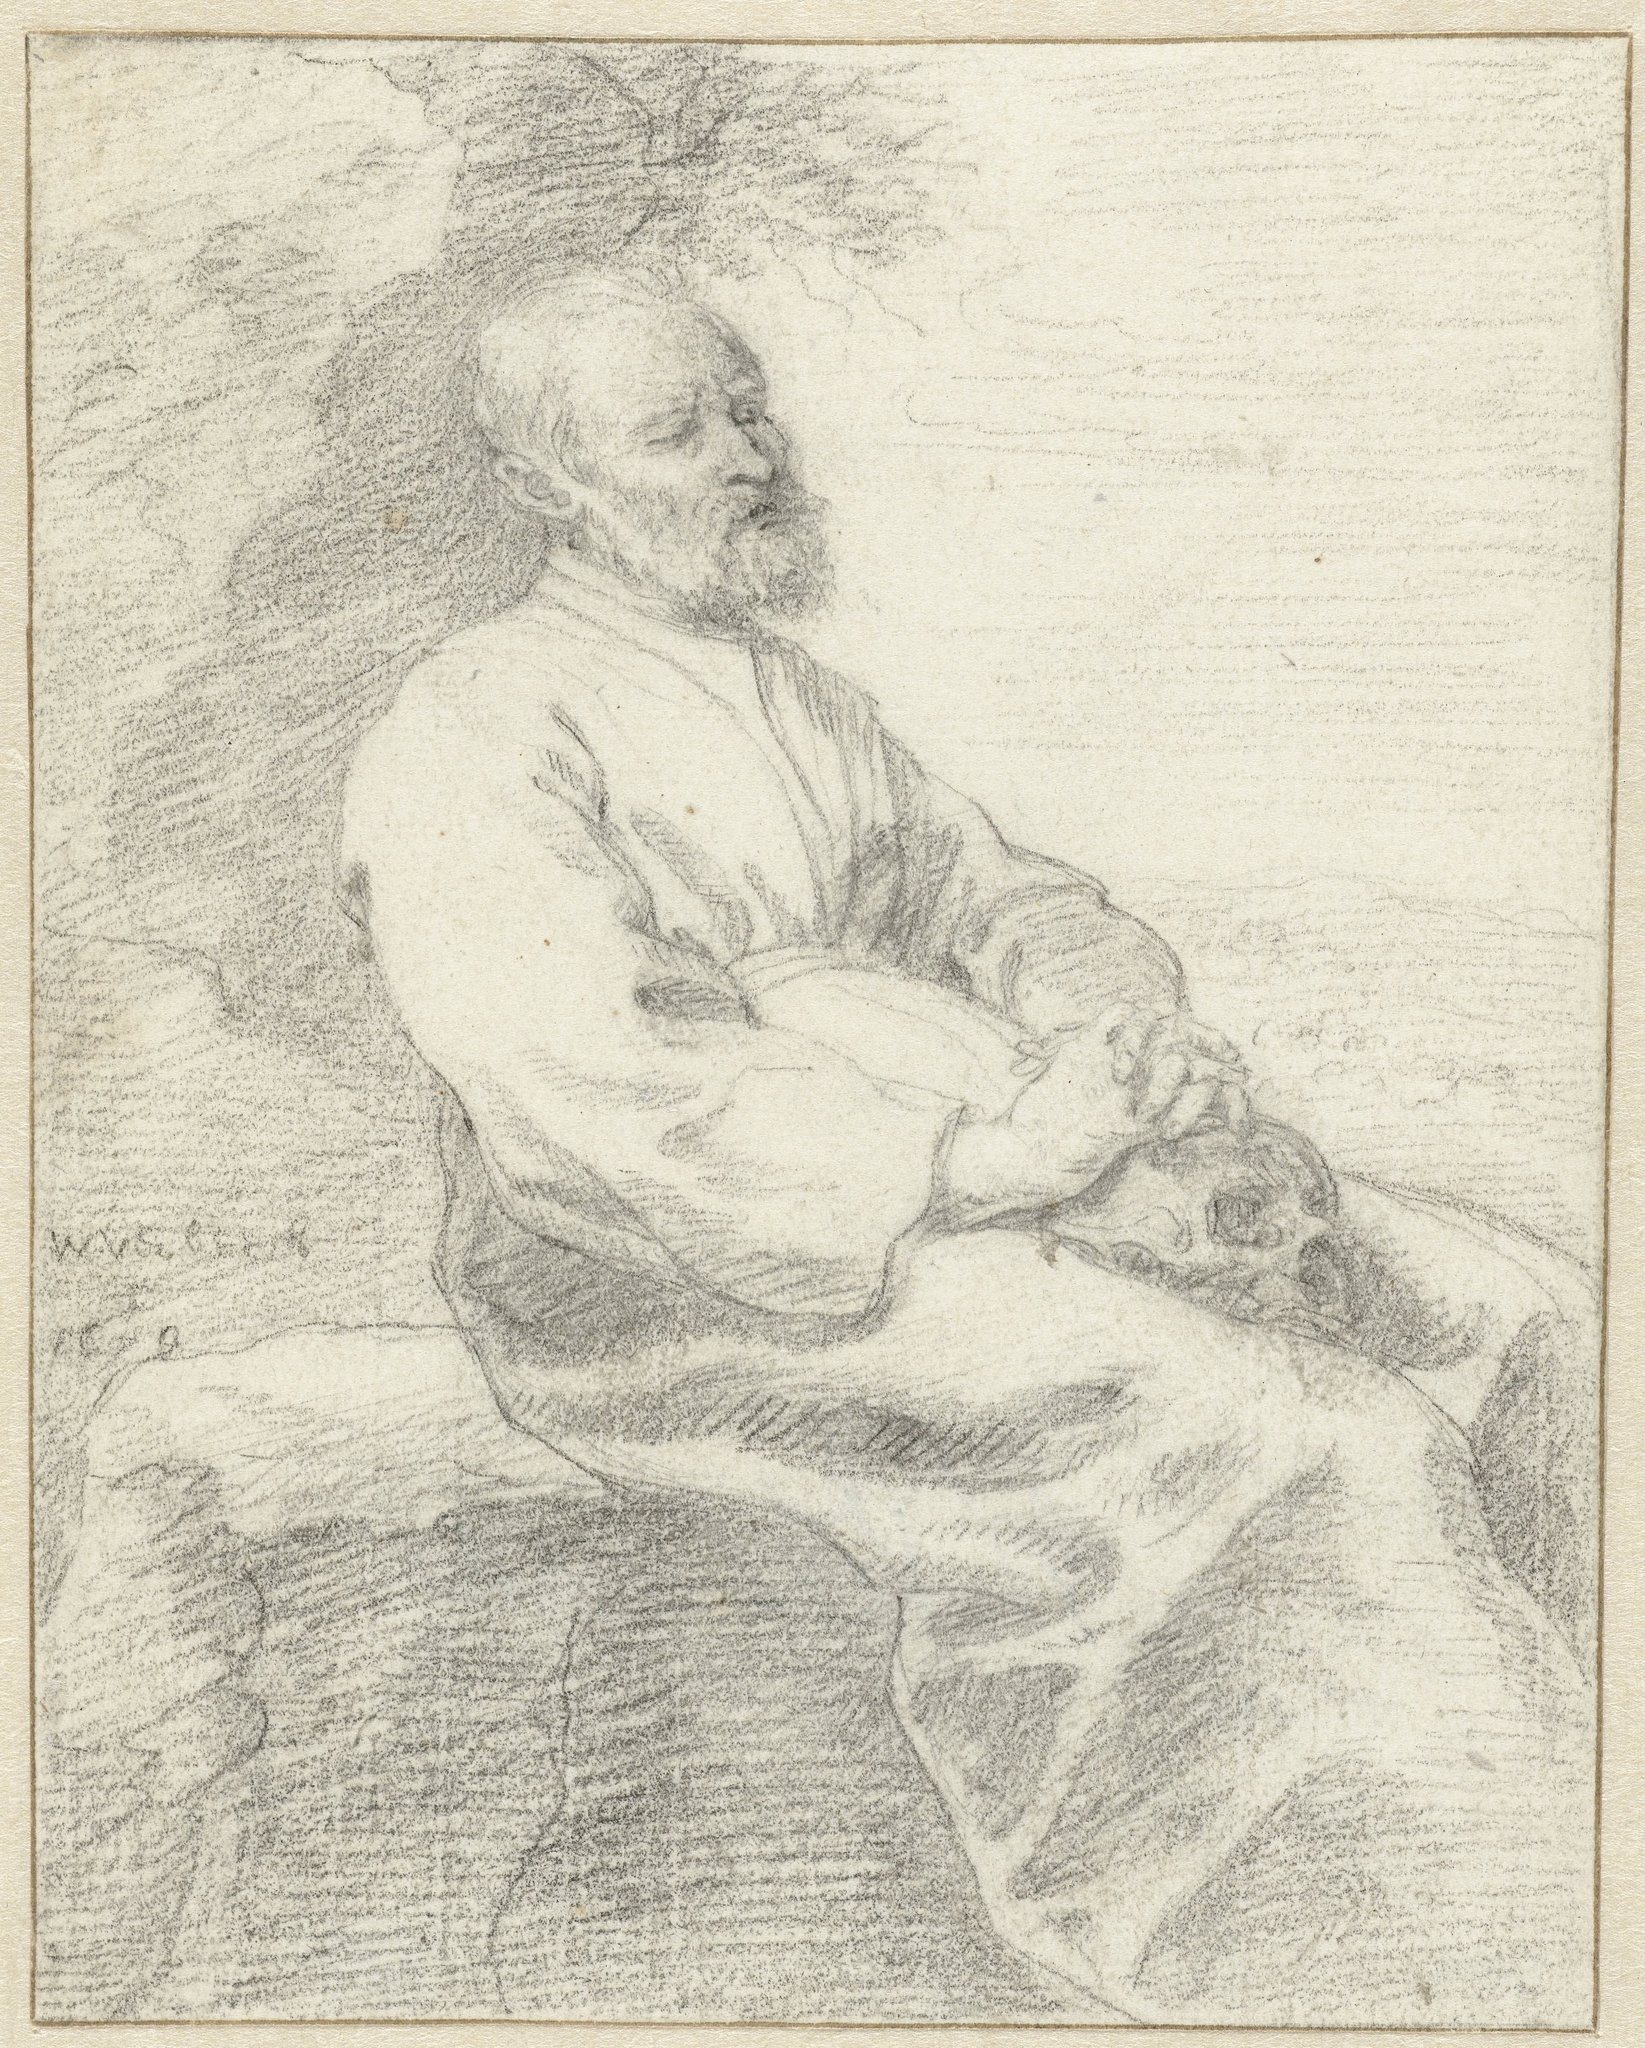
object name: drawing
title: Zittende kluizenaar met op zijn schoot een schedel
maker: w. verbeeck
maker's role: draughtsman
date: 1679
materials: chalk, paper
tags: anchorite, hermit, meditation over skull and/or crucifix, death's head, skull (symbol of death)